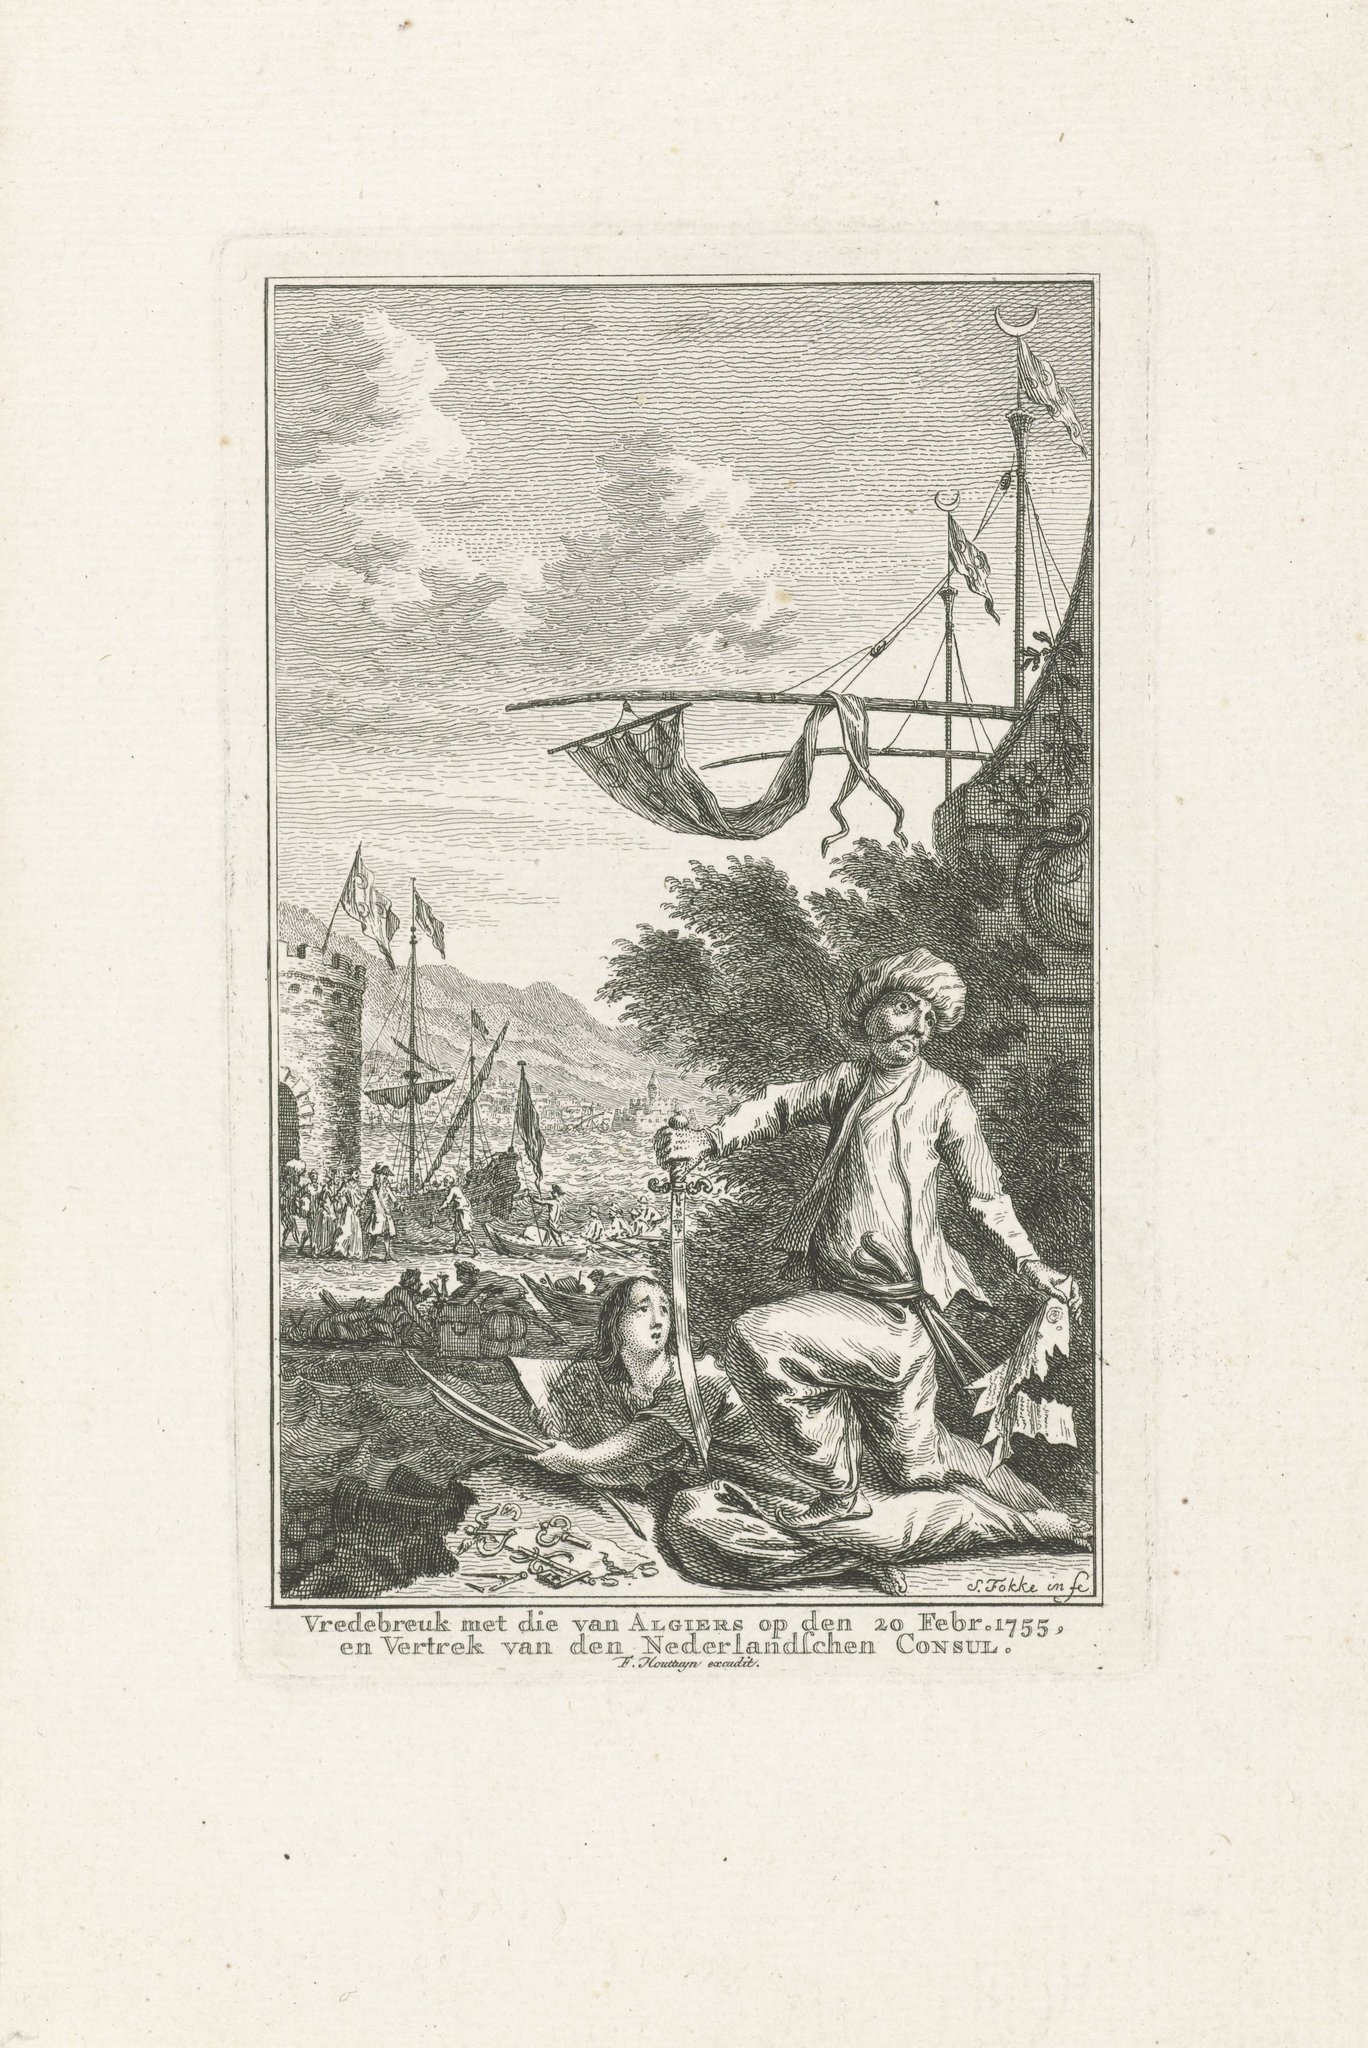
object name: print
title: Vredebreuk met die van Algiers op den 20 febr. 1755, en Vertrek van den Nederlandschen Consul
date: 1755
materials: paper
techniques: engraving, etching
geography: northern netherlands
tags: pirate, corsair, buccaneer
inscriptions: collector's mark: Lugt 2228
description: Allegorie op het verbreken van de vrede met Algiers en het daaropvolgende vertrek van de Nederlandse consul uit Algiers, 20 februari 1755. Een Algerijn (zeerover) met getrokken zwaard en verscheurd tractaat vertrapt een vrouwelijke personificatie (Vrije Koophandel?). Op de achtergrond verlaat de consul de stadspoort om aan boord van een schip te gaan.